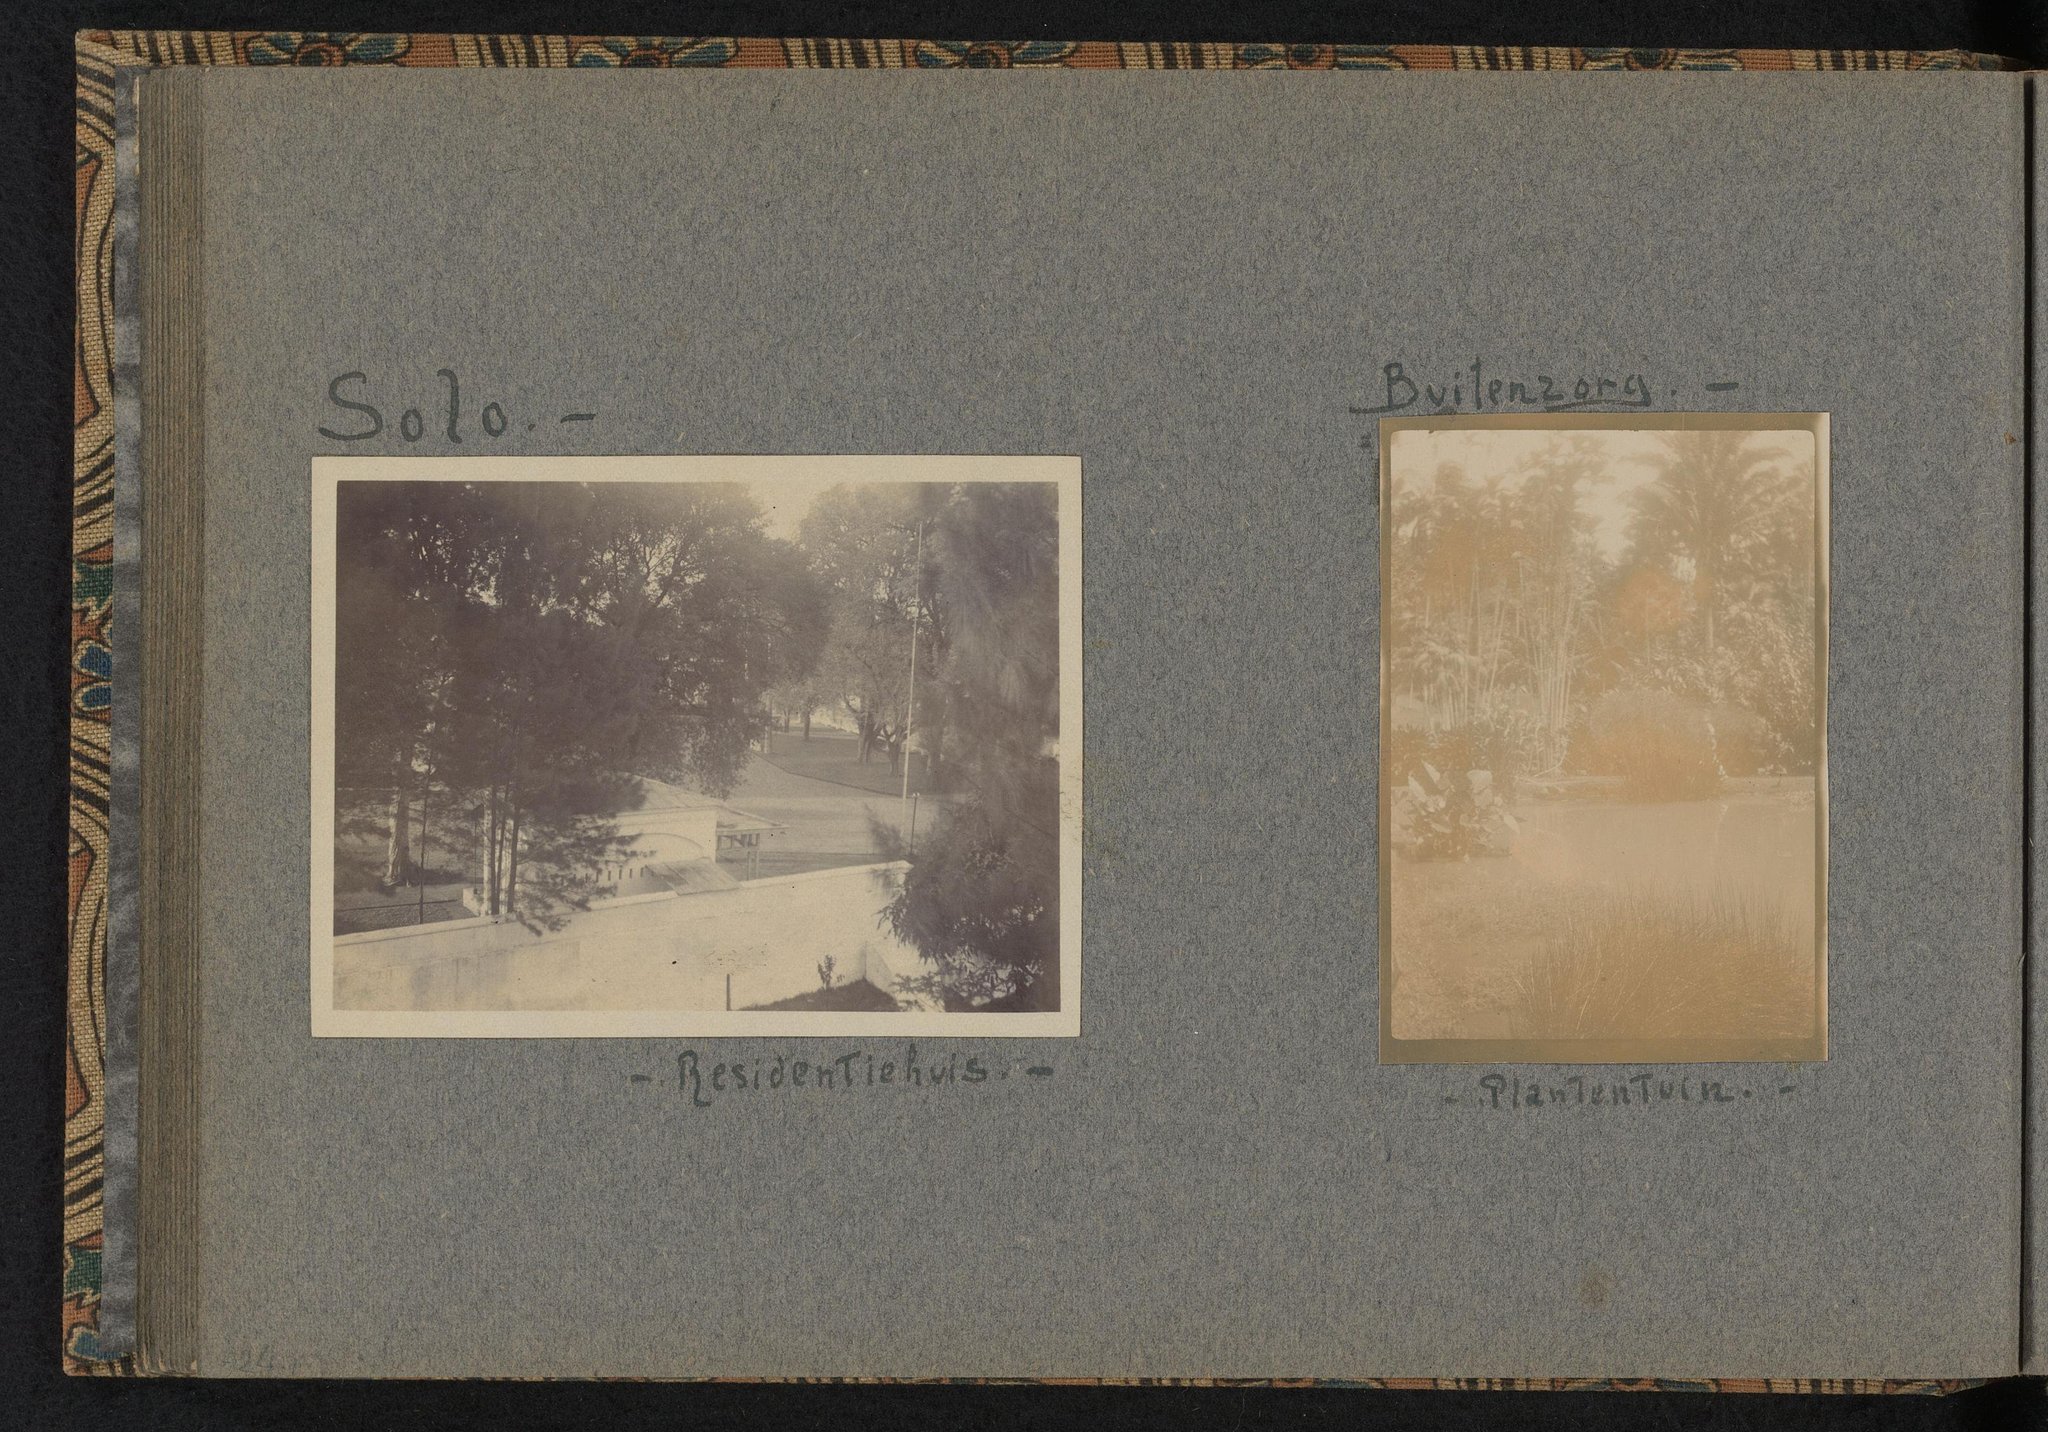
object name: album leaf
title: Gezicht vanuit het verblijfadres van het gezin van den Berg in Surakarta, en een gezicht op de tuin van het Paleis te Buitenzorg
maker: karel frederik van den berg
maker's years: 1873-1948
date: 1921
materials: paper, cardboard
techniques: gelatin silver print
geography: java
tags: garden, street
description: Deze foto's zijn onderdeel van een album.